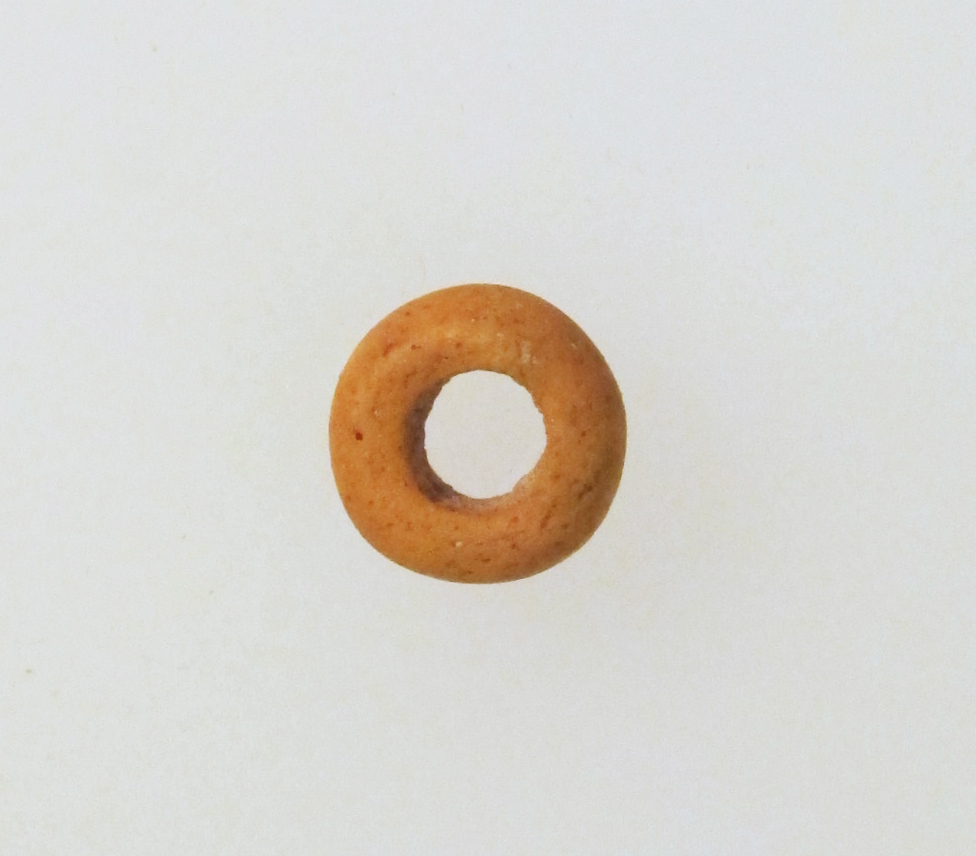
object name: bead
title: Glass bead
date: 7000 BCE-330 CE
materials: glass